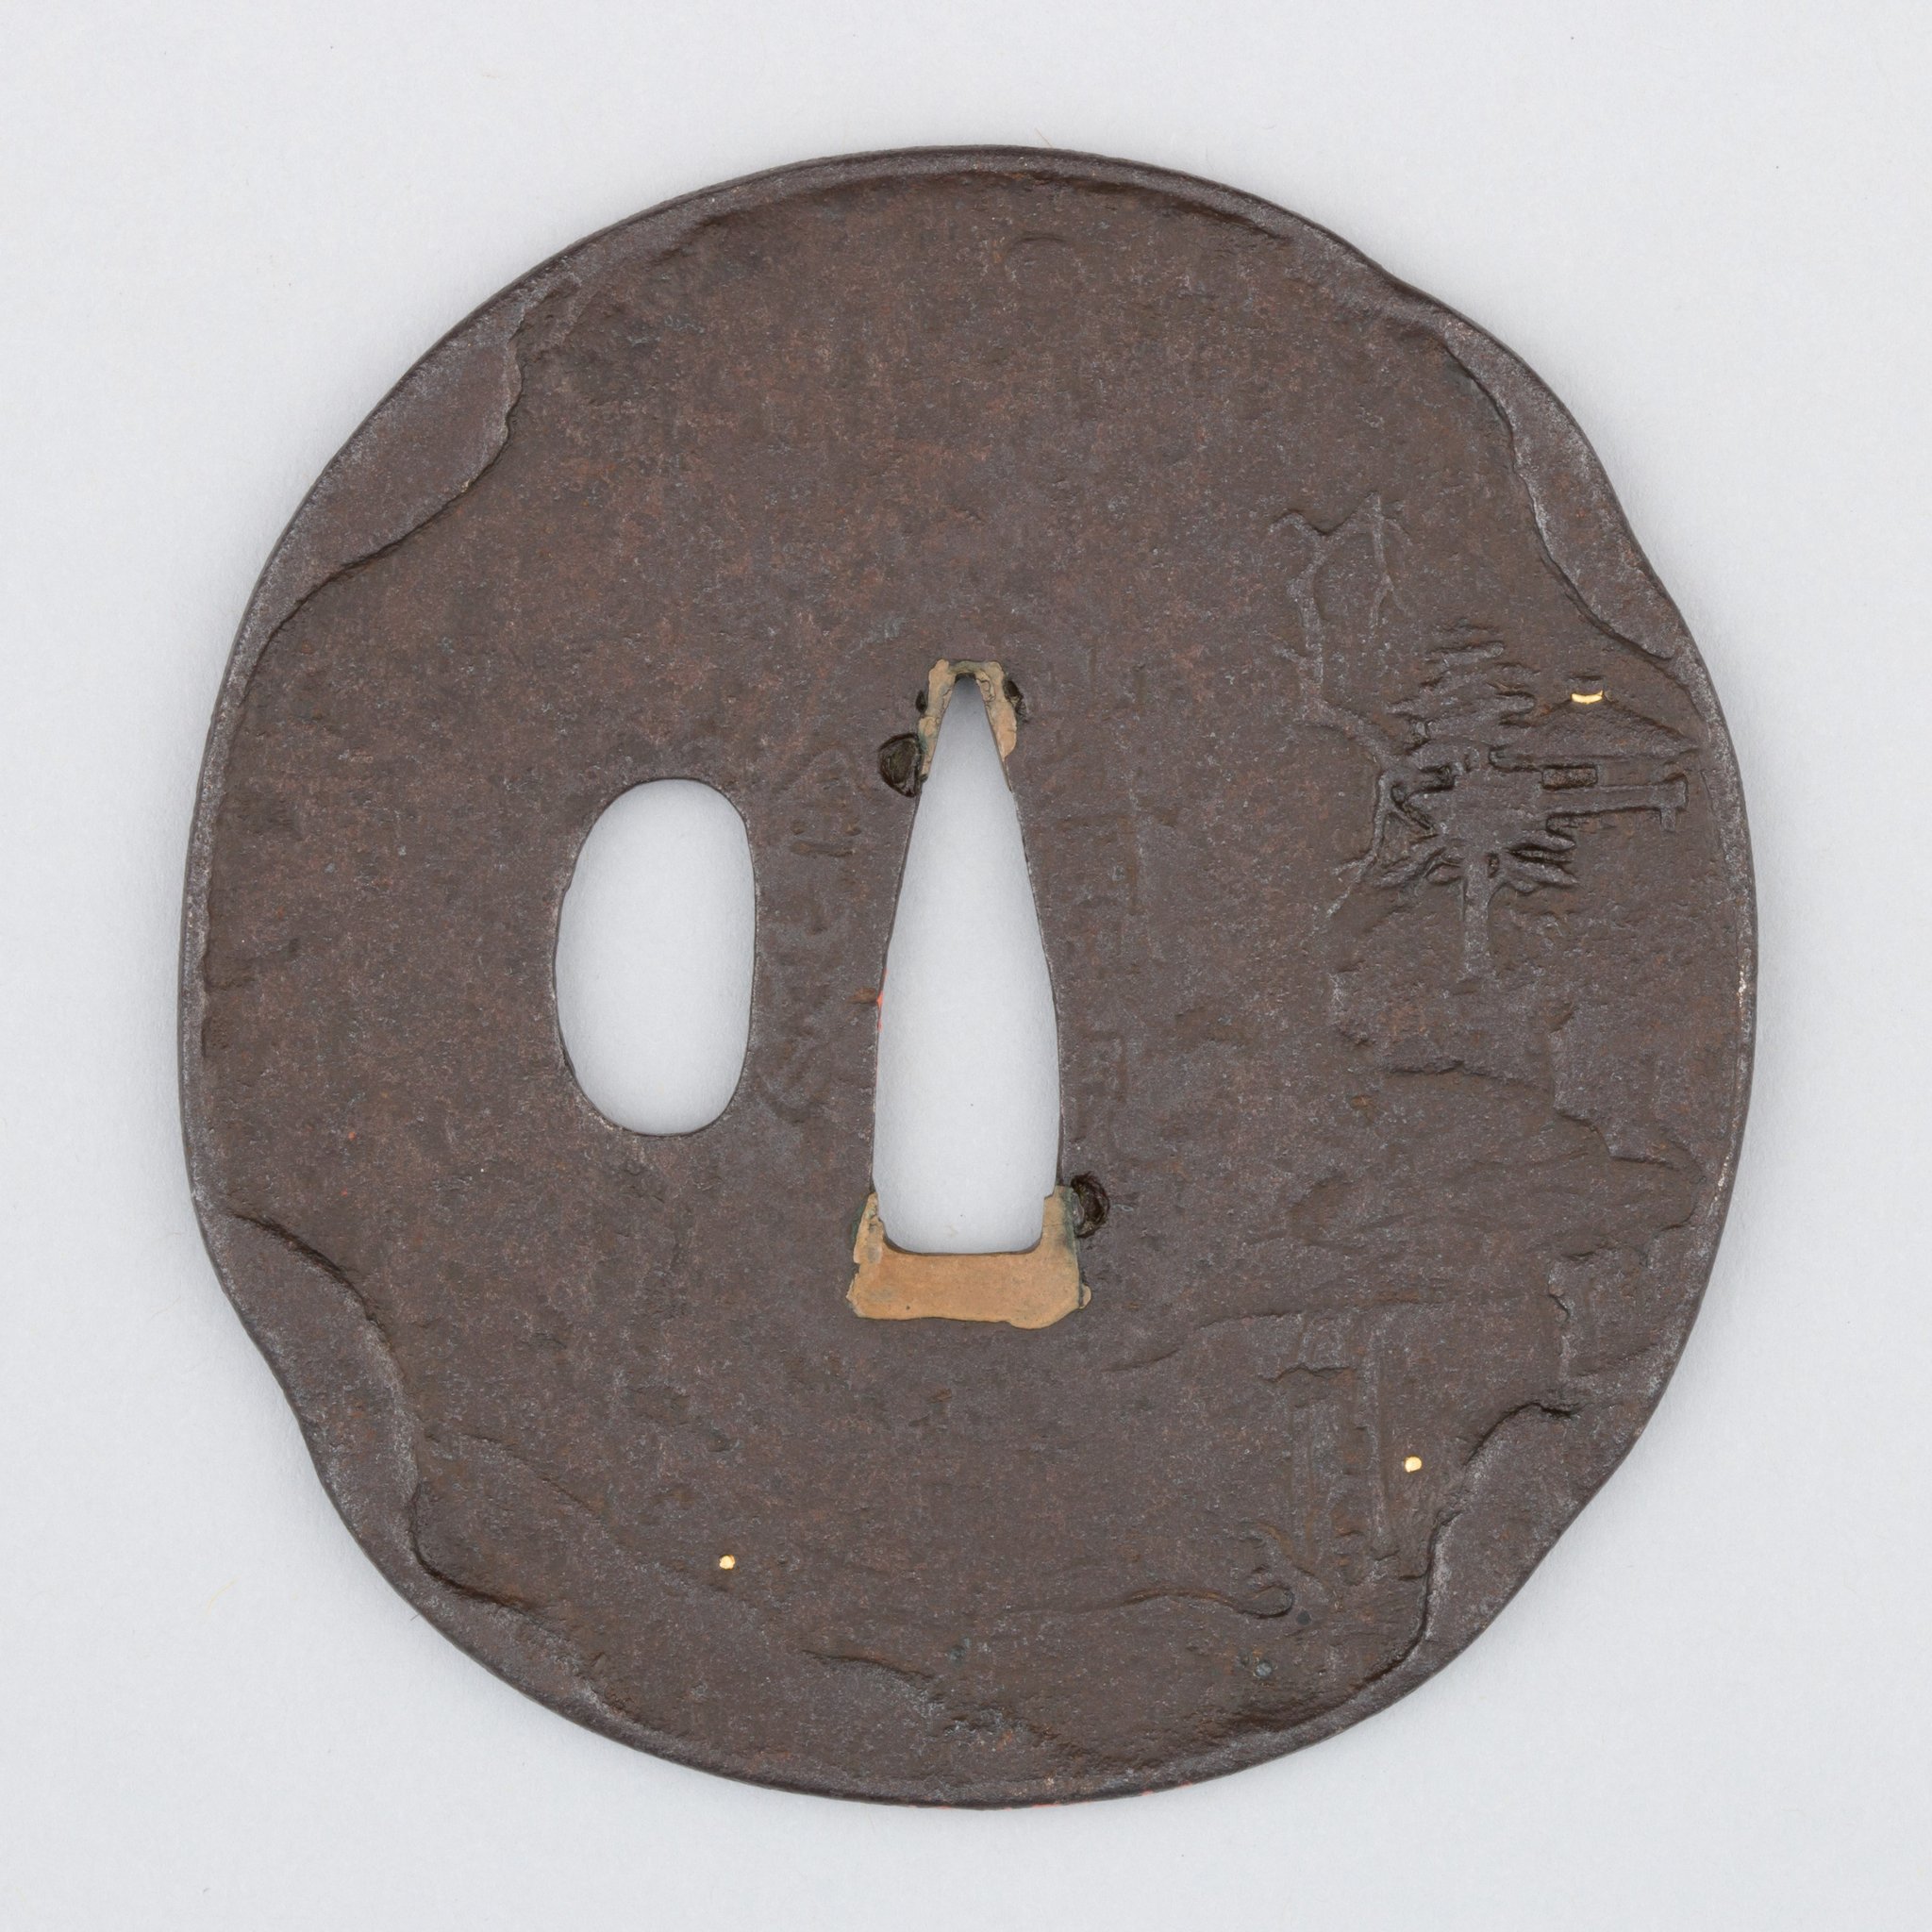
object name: sword guard tsuba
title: Sword Guard (Tsuba)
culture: japanese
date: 1750-1800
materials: copper, gold, iron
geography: japan